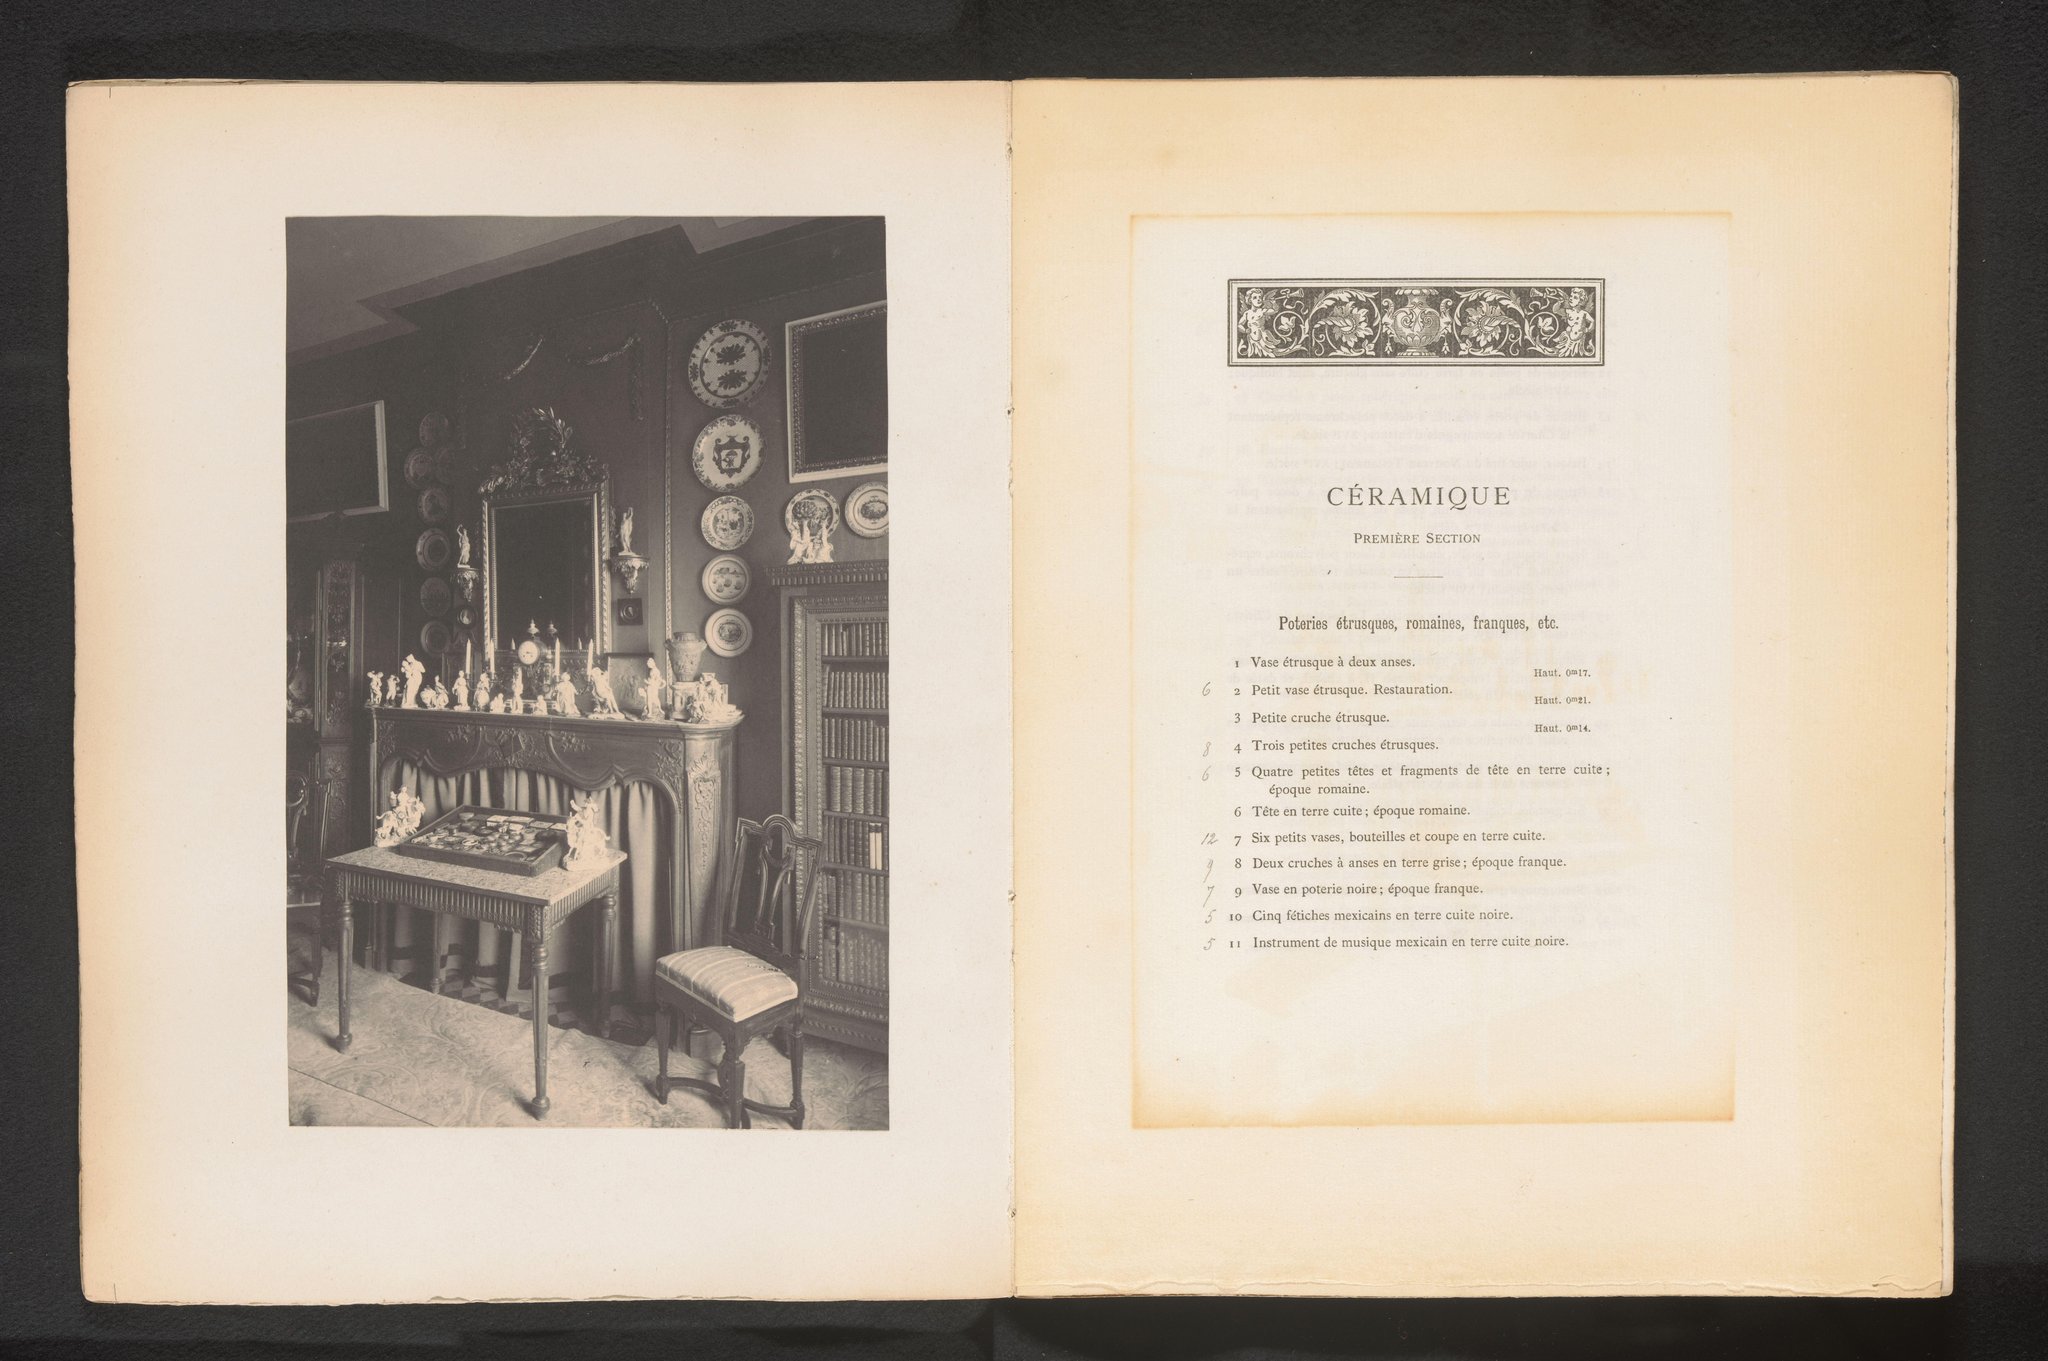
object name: photograph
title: Kamer in het huis van Antonin Terme met zijn collectie antiquiteiten, borden en beelden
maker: Anonymous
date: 1880-1885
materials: photographic support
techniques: platinum process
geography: liège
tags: art collection, art gallery, dish, plate, saucer, other rooms